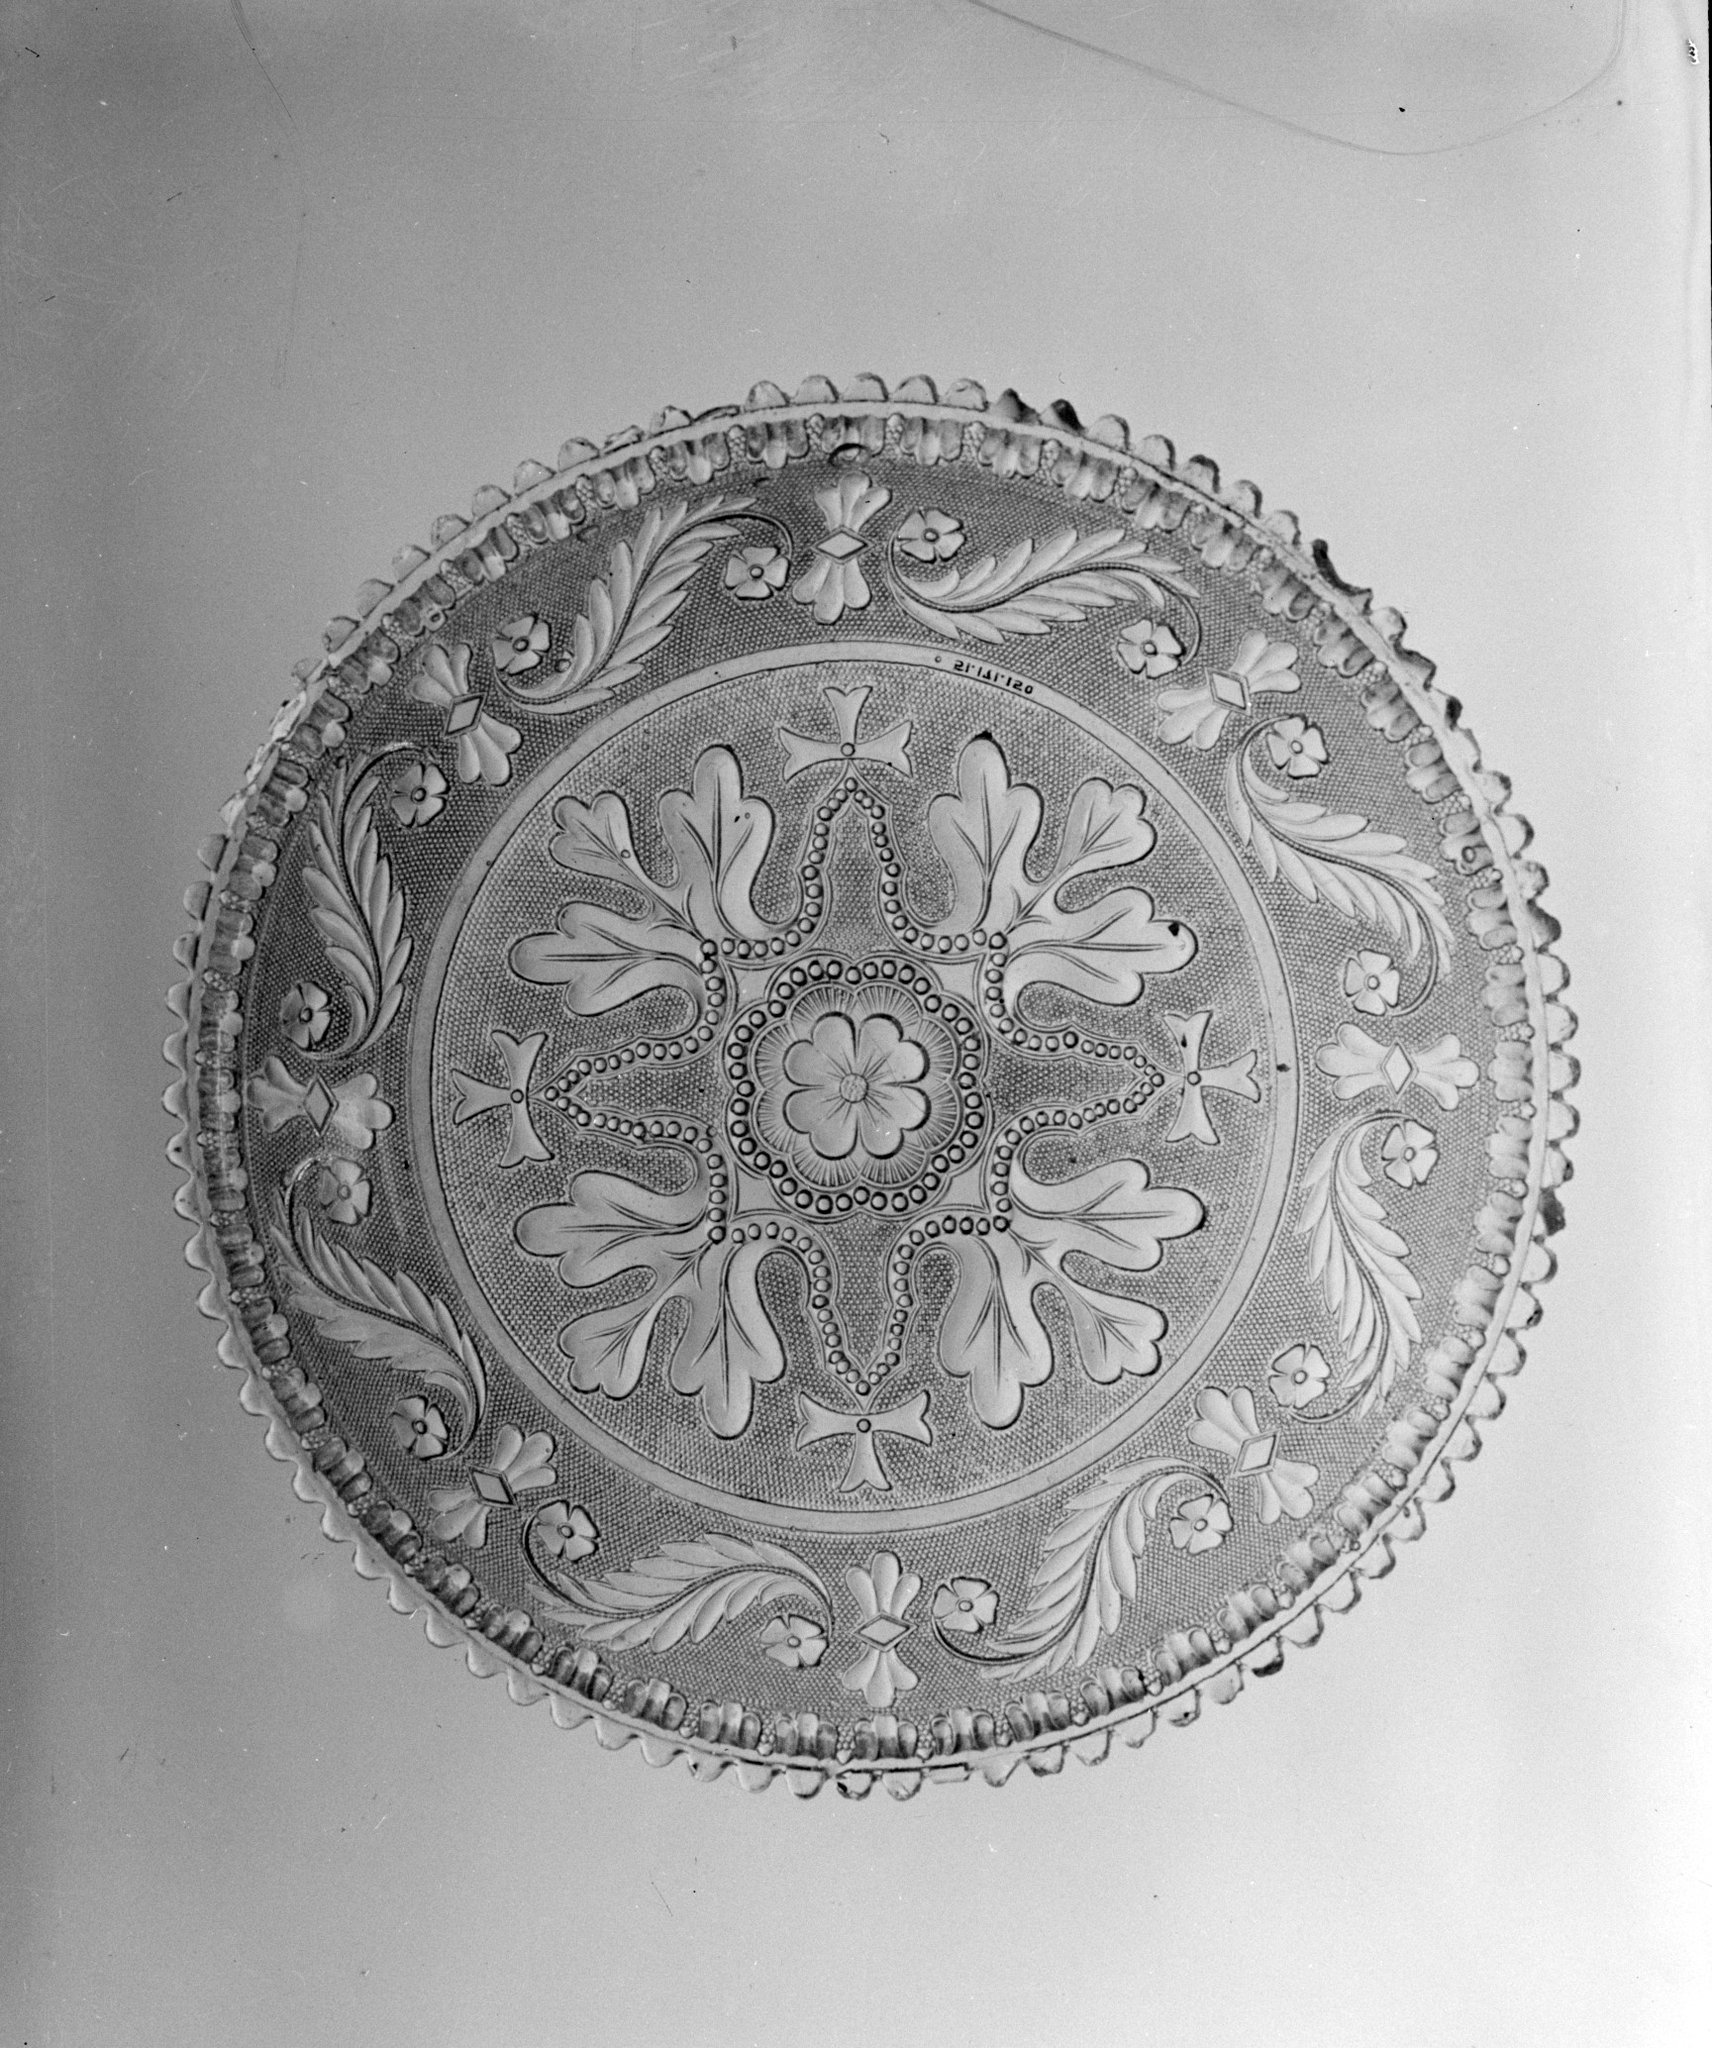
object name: bowl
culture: american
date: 1835-1840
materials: glass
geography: united states